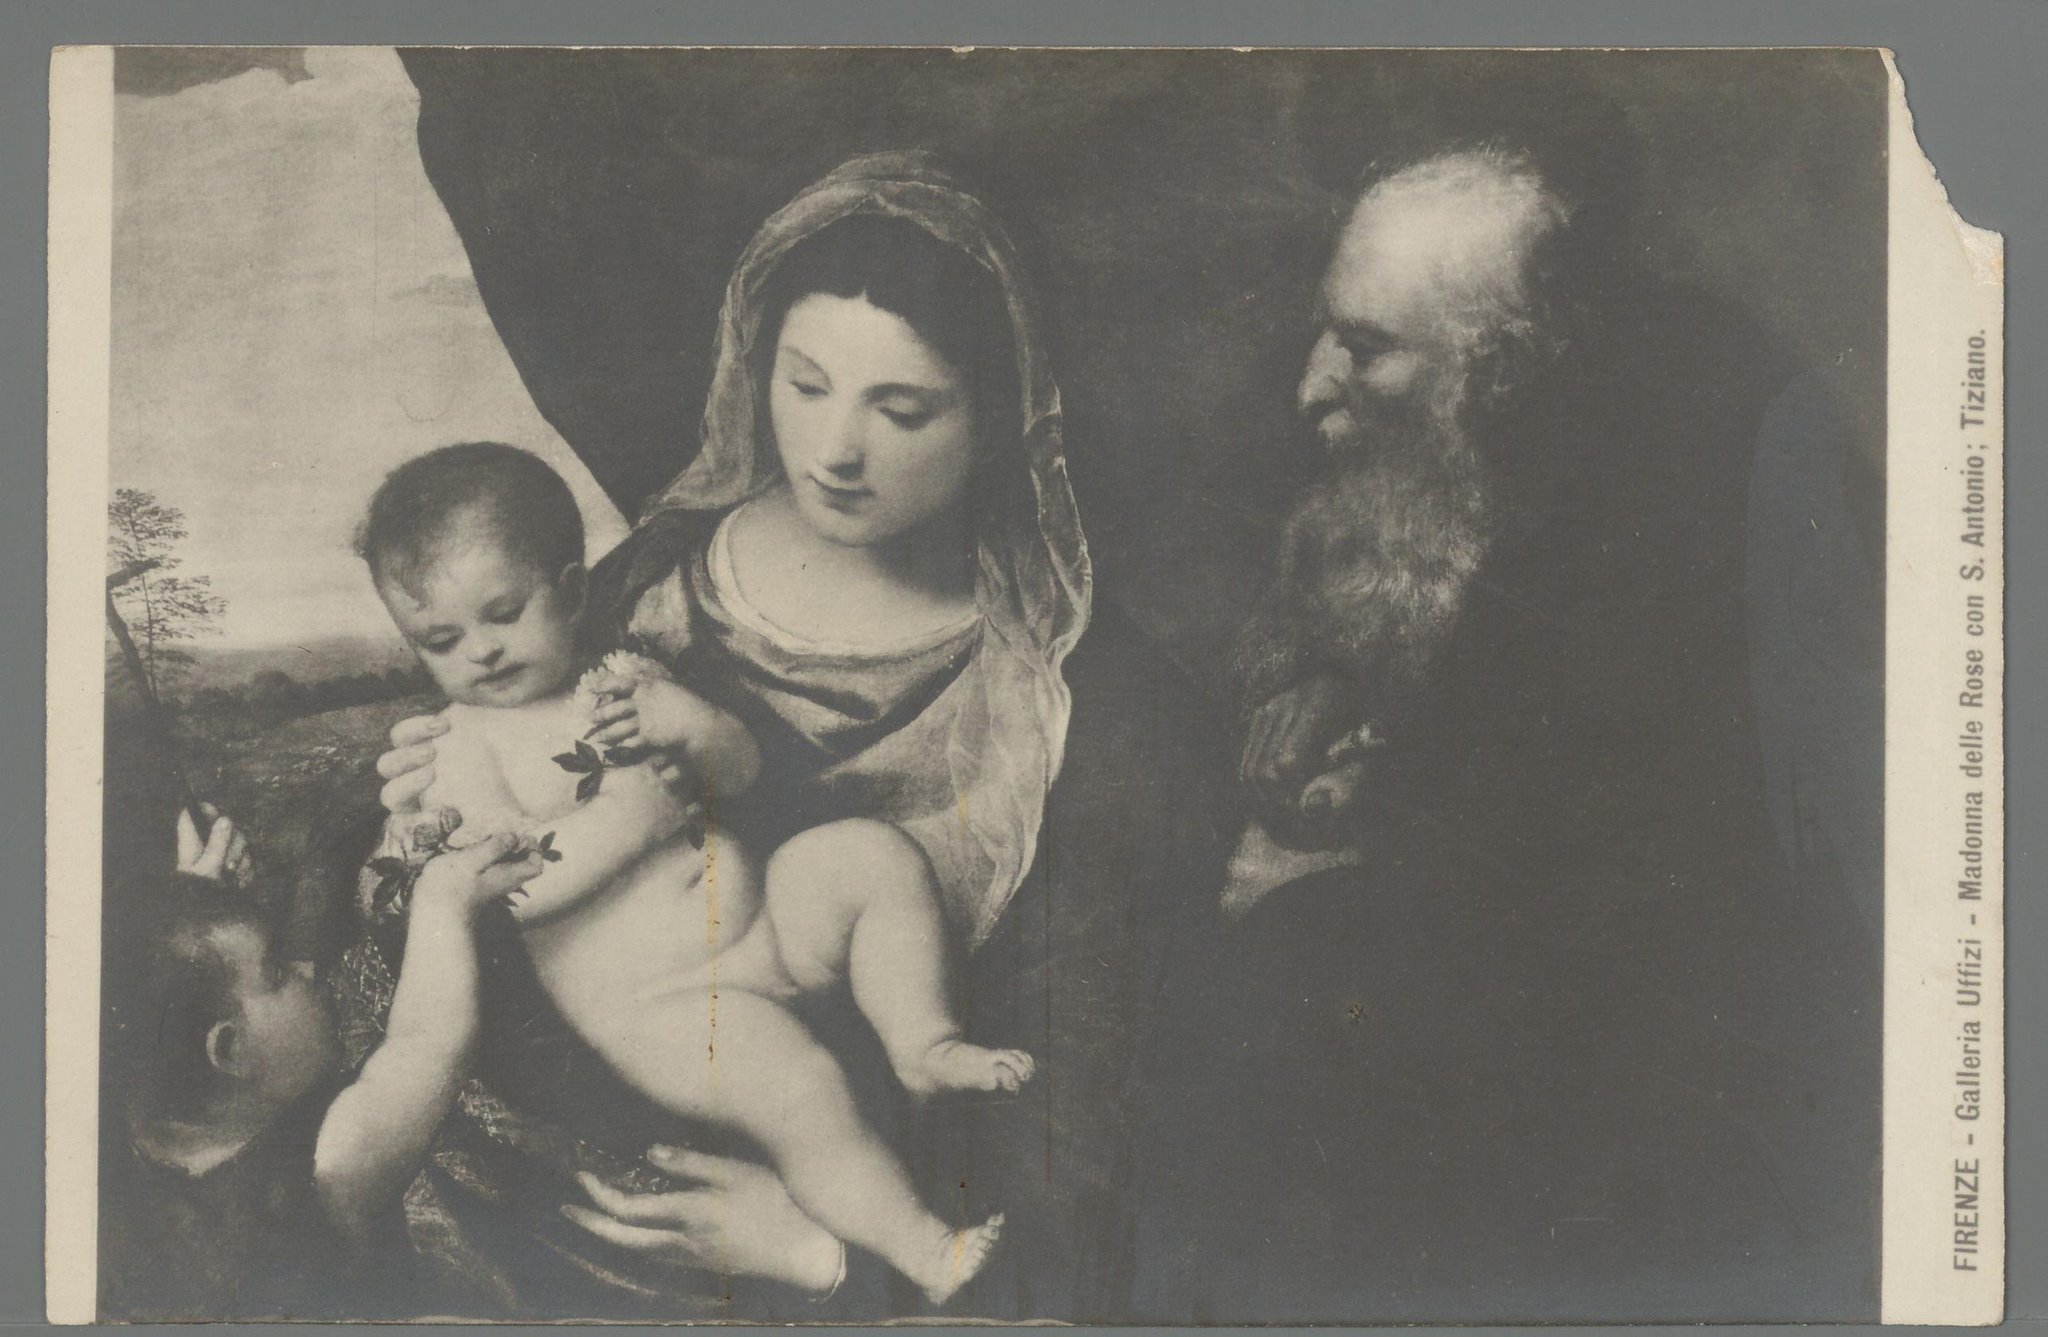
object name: ansichtkaart, prentbriefkaart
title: Firenze. Galleria Uffizi. Madonna delle Rose con S. Antonio; Tiziano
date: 1906-1930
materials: photographic support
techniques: photography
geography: florence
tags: madonna: mary sitting or enthroned, the christ-child in her lap (or in front of her bosom) (mary sometimes represented half-length), antoninus pierozzi, dominican friar and archbishop of florence; possible attributes: book, scales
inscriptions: collector's mark: ‘AFE v S’